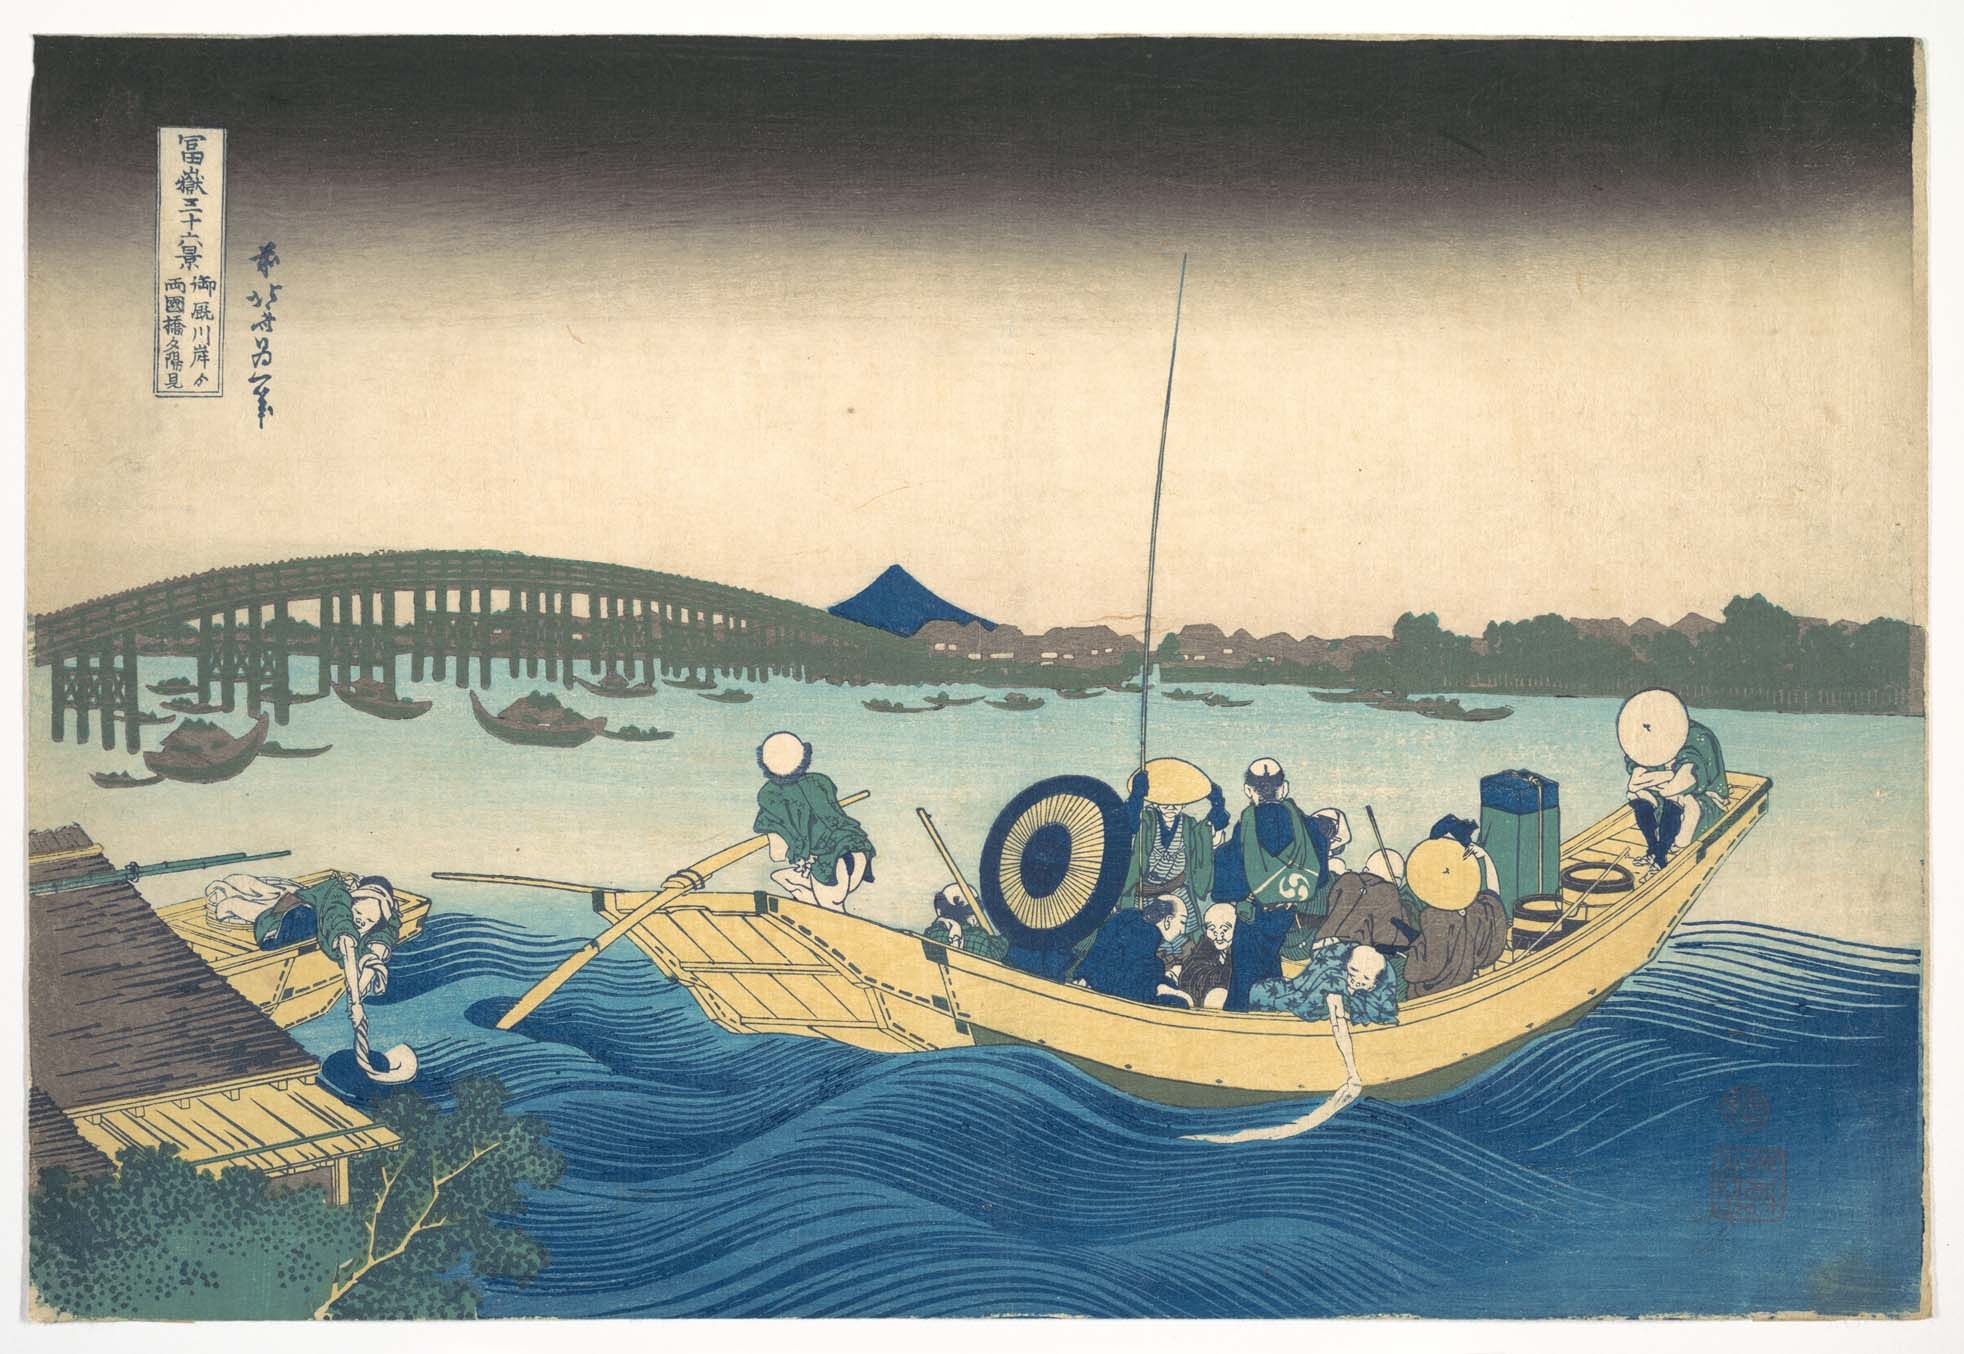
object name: woodblock print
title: Viewing the Sunset over Ryōgoku Bridge from the Onmaya Embankment (Onmayagashi yori Ryōgokubashi sekiyō o miru), from the series Thirty-six Views of Mount Fuji (Fugaku sanjūrokkei)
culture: japanese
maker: katsushika hokusai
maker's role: artist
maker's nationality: japanese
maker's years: 1760-1849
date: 1830-1832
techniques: woodblock print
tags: human figures,bridges,boats